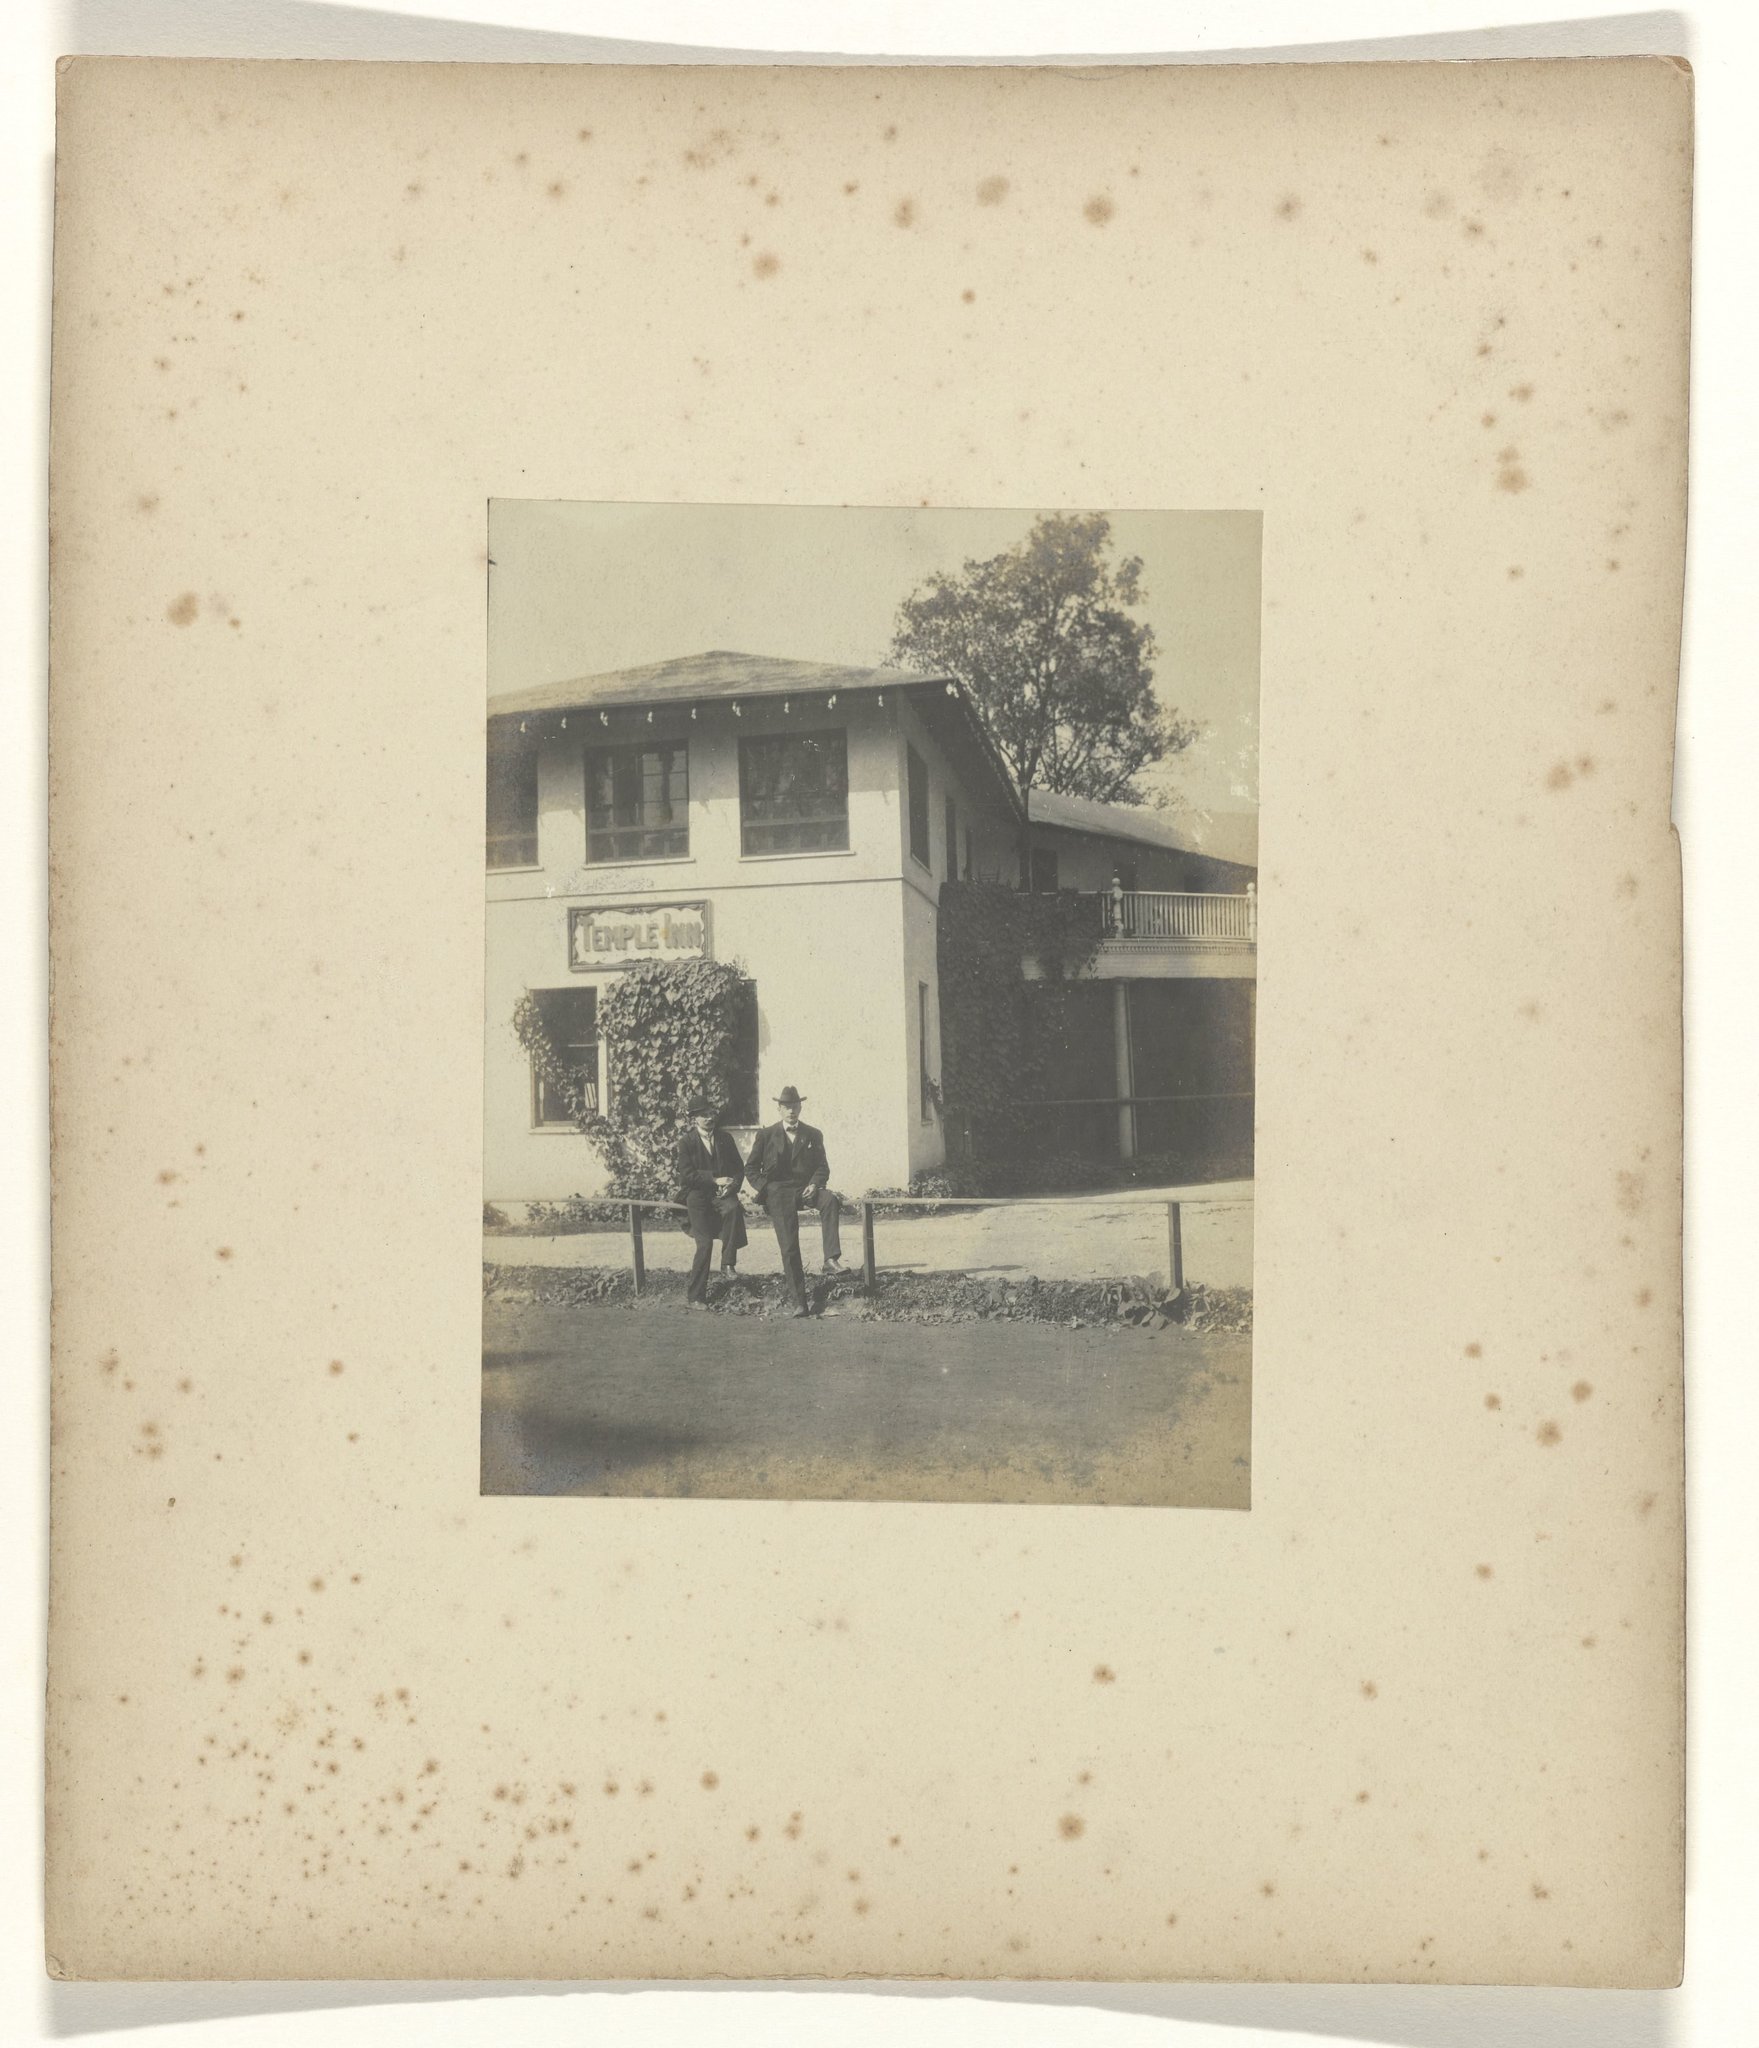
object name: photograph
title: Jan C. Schüller en Backers voor de Temple Inn tijdens de wereldtentoonstelling in St. Louis (Louisiana Purchase Exposition), 1904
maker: Anonymous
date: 1904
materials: cardboard, paper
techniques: gelatin silver print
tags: painter, print maker, draughtsman, jan schüller, world fair, world exhibition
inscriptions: annotation: ‘Zondagmorgen 30 Oct // met Backers’, annotation: ‘rechts Jan C. Schüller’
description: Jan C. Schüller en Backers voor de Temple Inn tijdens de wereldtentoonstelling in St. Louis (Louisiana Purchase Exposition), 1904.